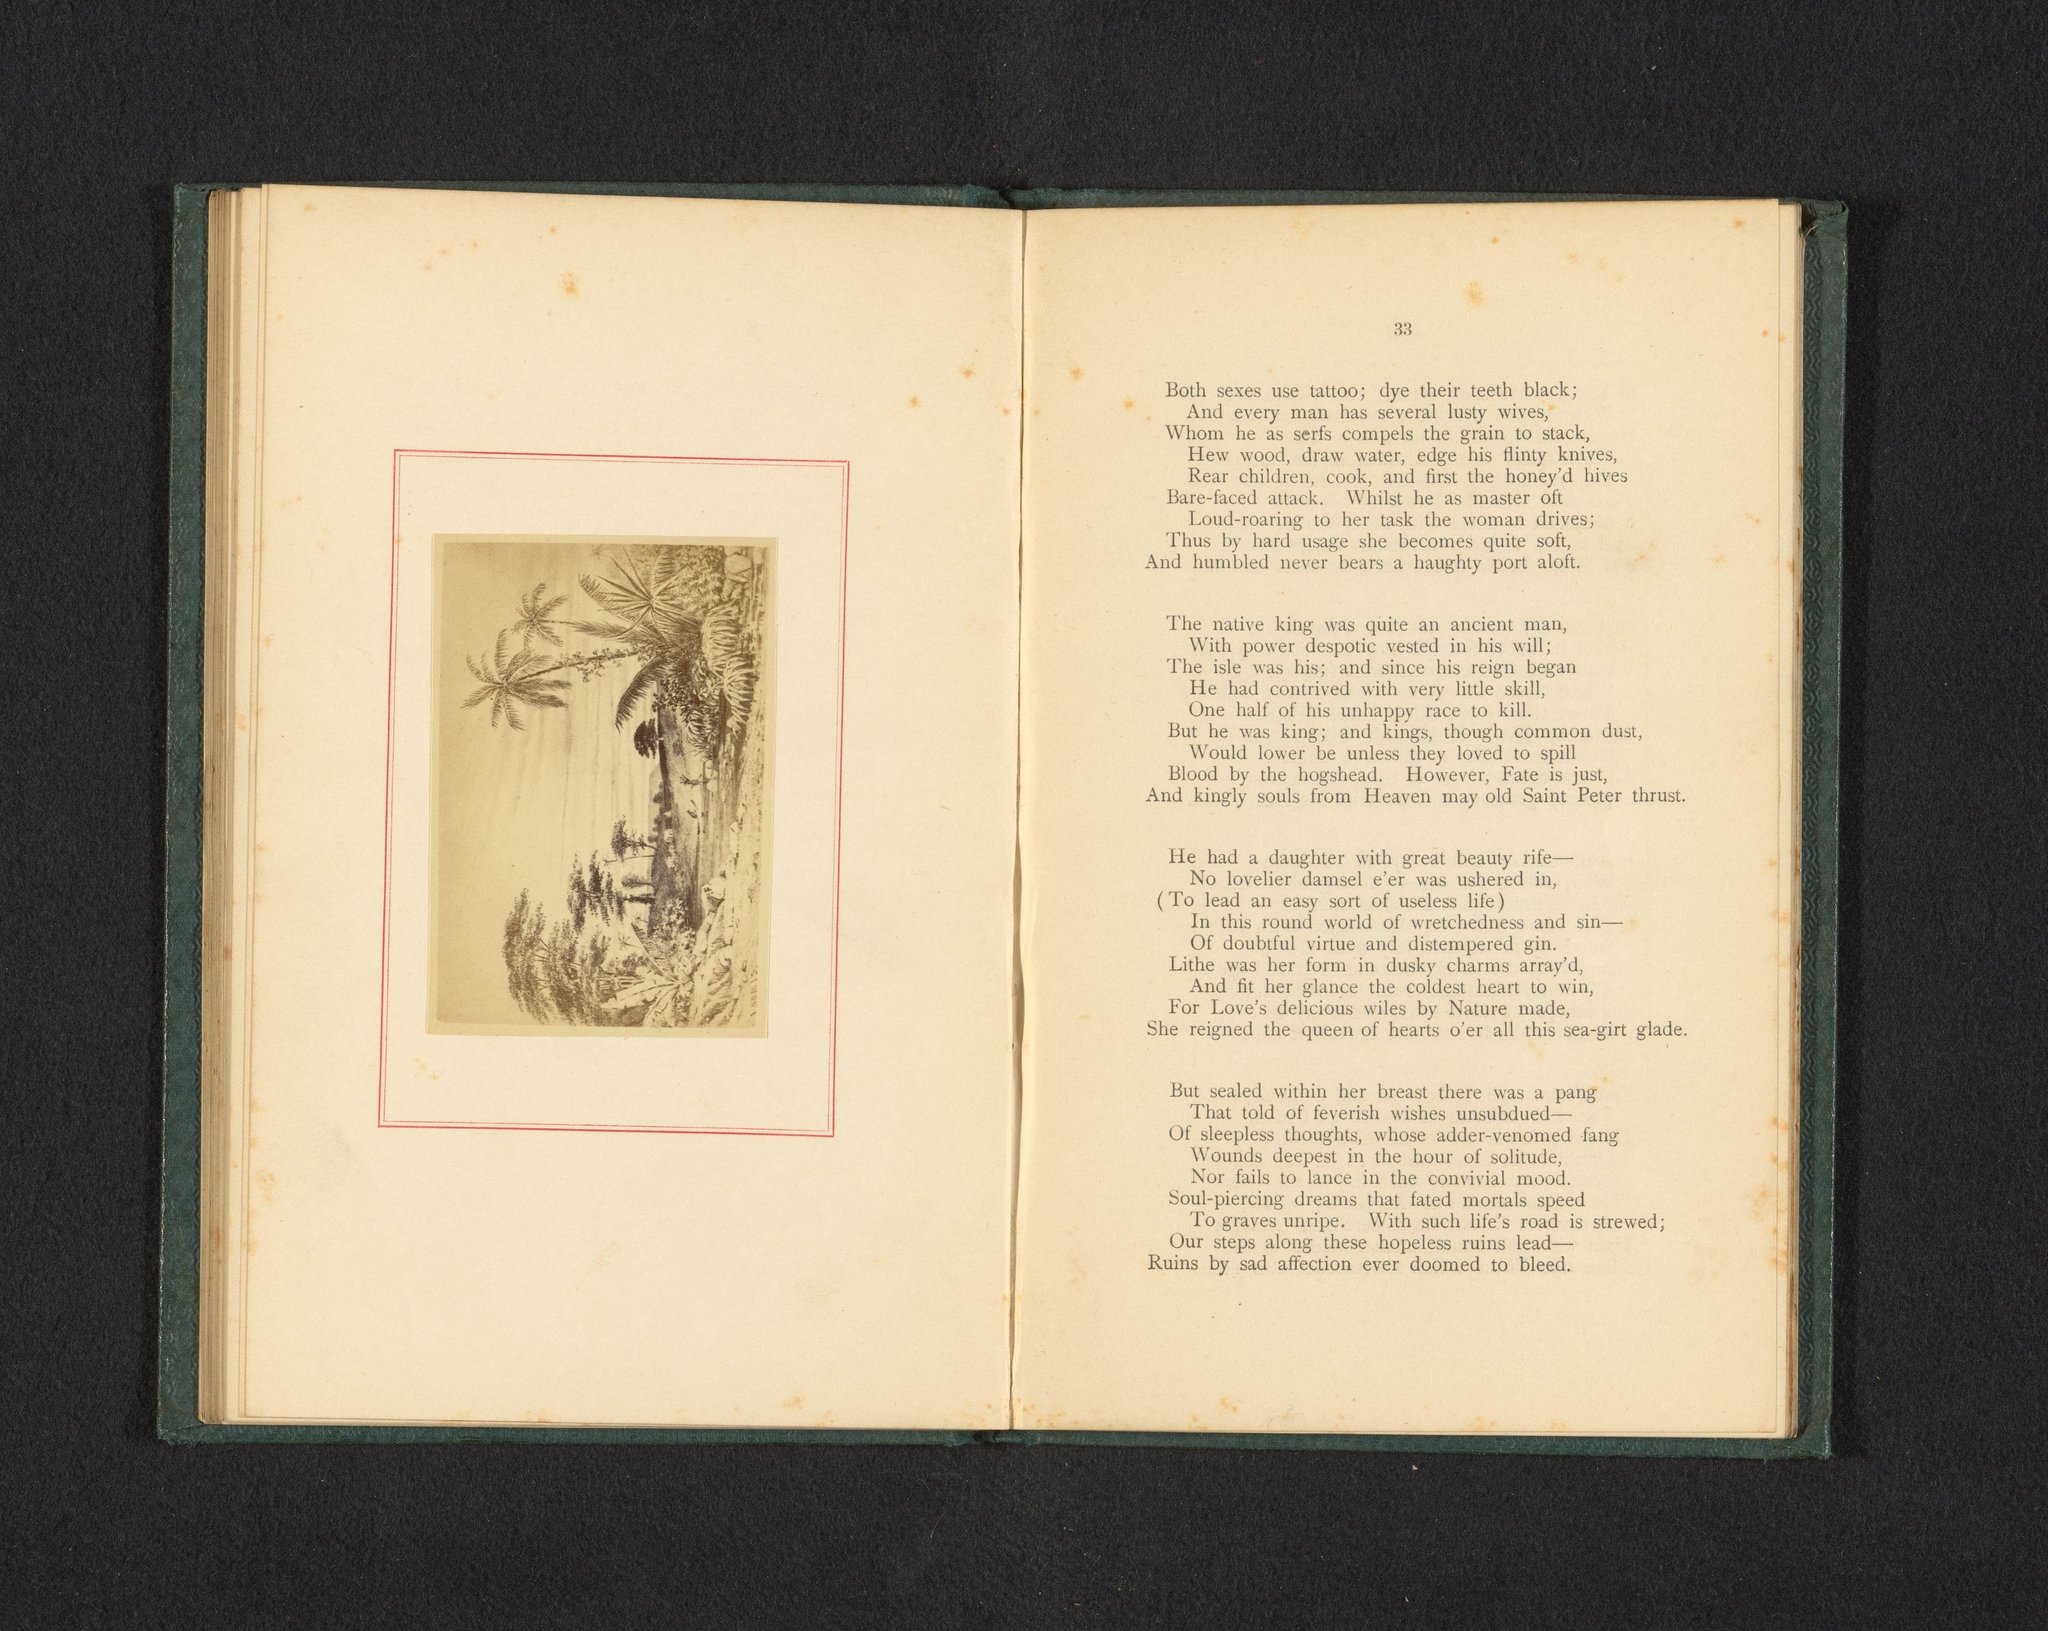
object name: page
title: Fotoreproductie van een schilderij, voorstellende een landschap met palmbomen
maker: flaglor and perkins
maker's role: fotograaf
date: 1866-1871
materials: photographic support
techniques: albumen print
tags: landscapes in tropical and sub-tropical regions, trees: palm-tree